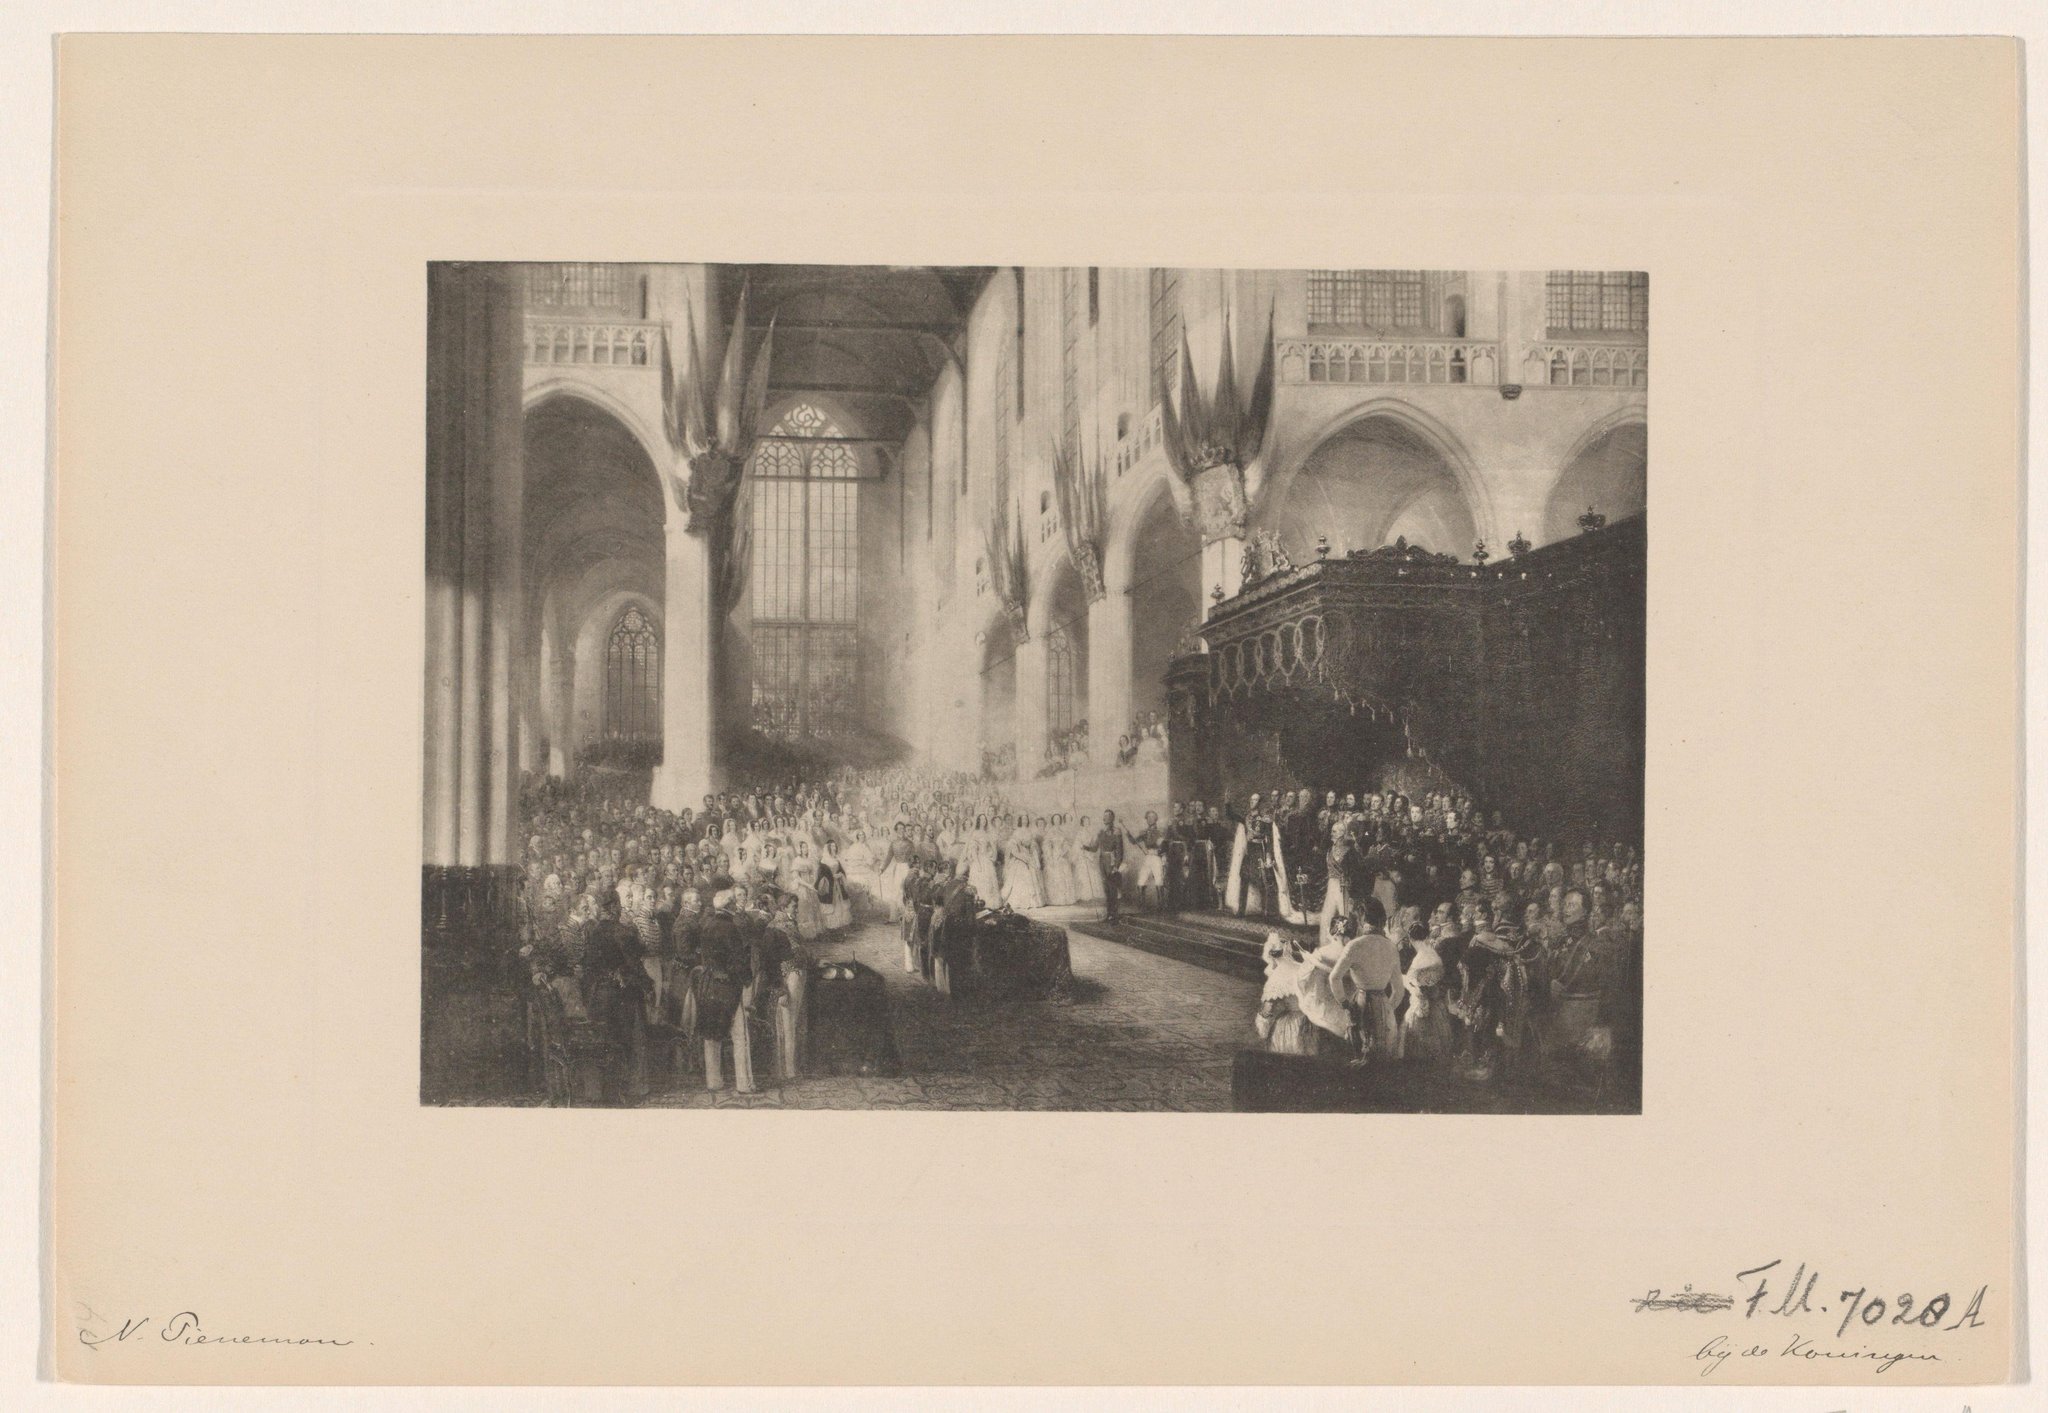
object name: reproduction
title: Inhuldiging van Z.M. Willem II. In de Nieuwe Kerk te Amsterdam den 28 November 1840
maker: Anonymous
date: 1845-1850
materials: paper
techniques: printing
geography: netherlands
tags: the hague, william ii of the netherlands, new ruler taking the oath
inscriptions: collector's mark: Lugt 2228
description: Inhuldiging van koning Willem II in de Nieuwe Kerk te Amsterdam op 28 november 1840. De koning legt staande voor de troon de eed af.